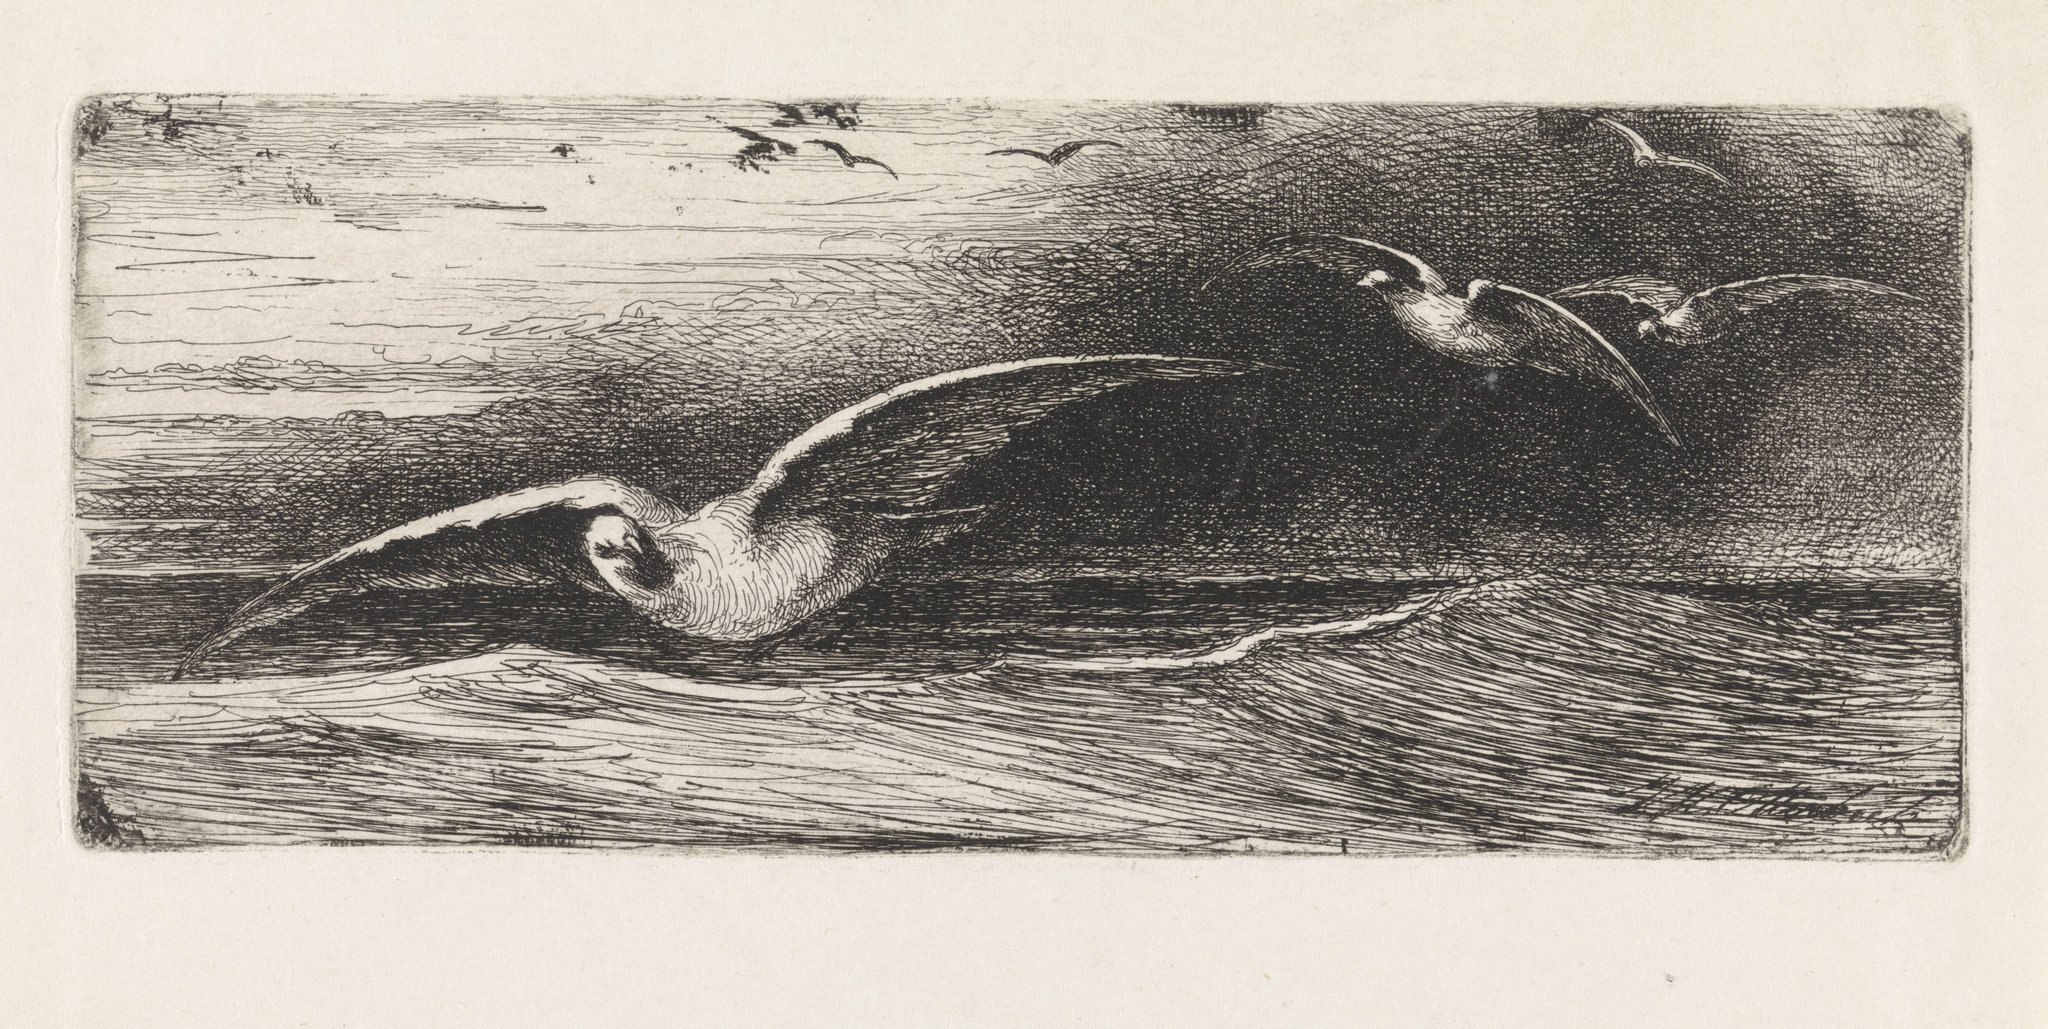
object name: print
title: Zeemeeuwen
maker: jacobus hermanus otterbeek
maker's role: painter, print maker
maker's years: 1839-1902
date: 1854-1902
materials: paper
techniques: etching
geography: the hague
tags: shore-birds and wading-birds: gull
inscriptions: collector's mark: Lugt 2228